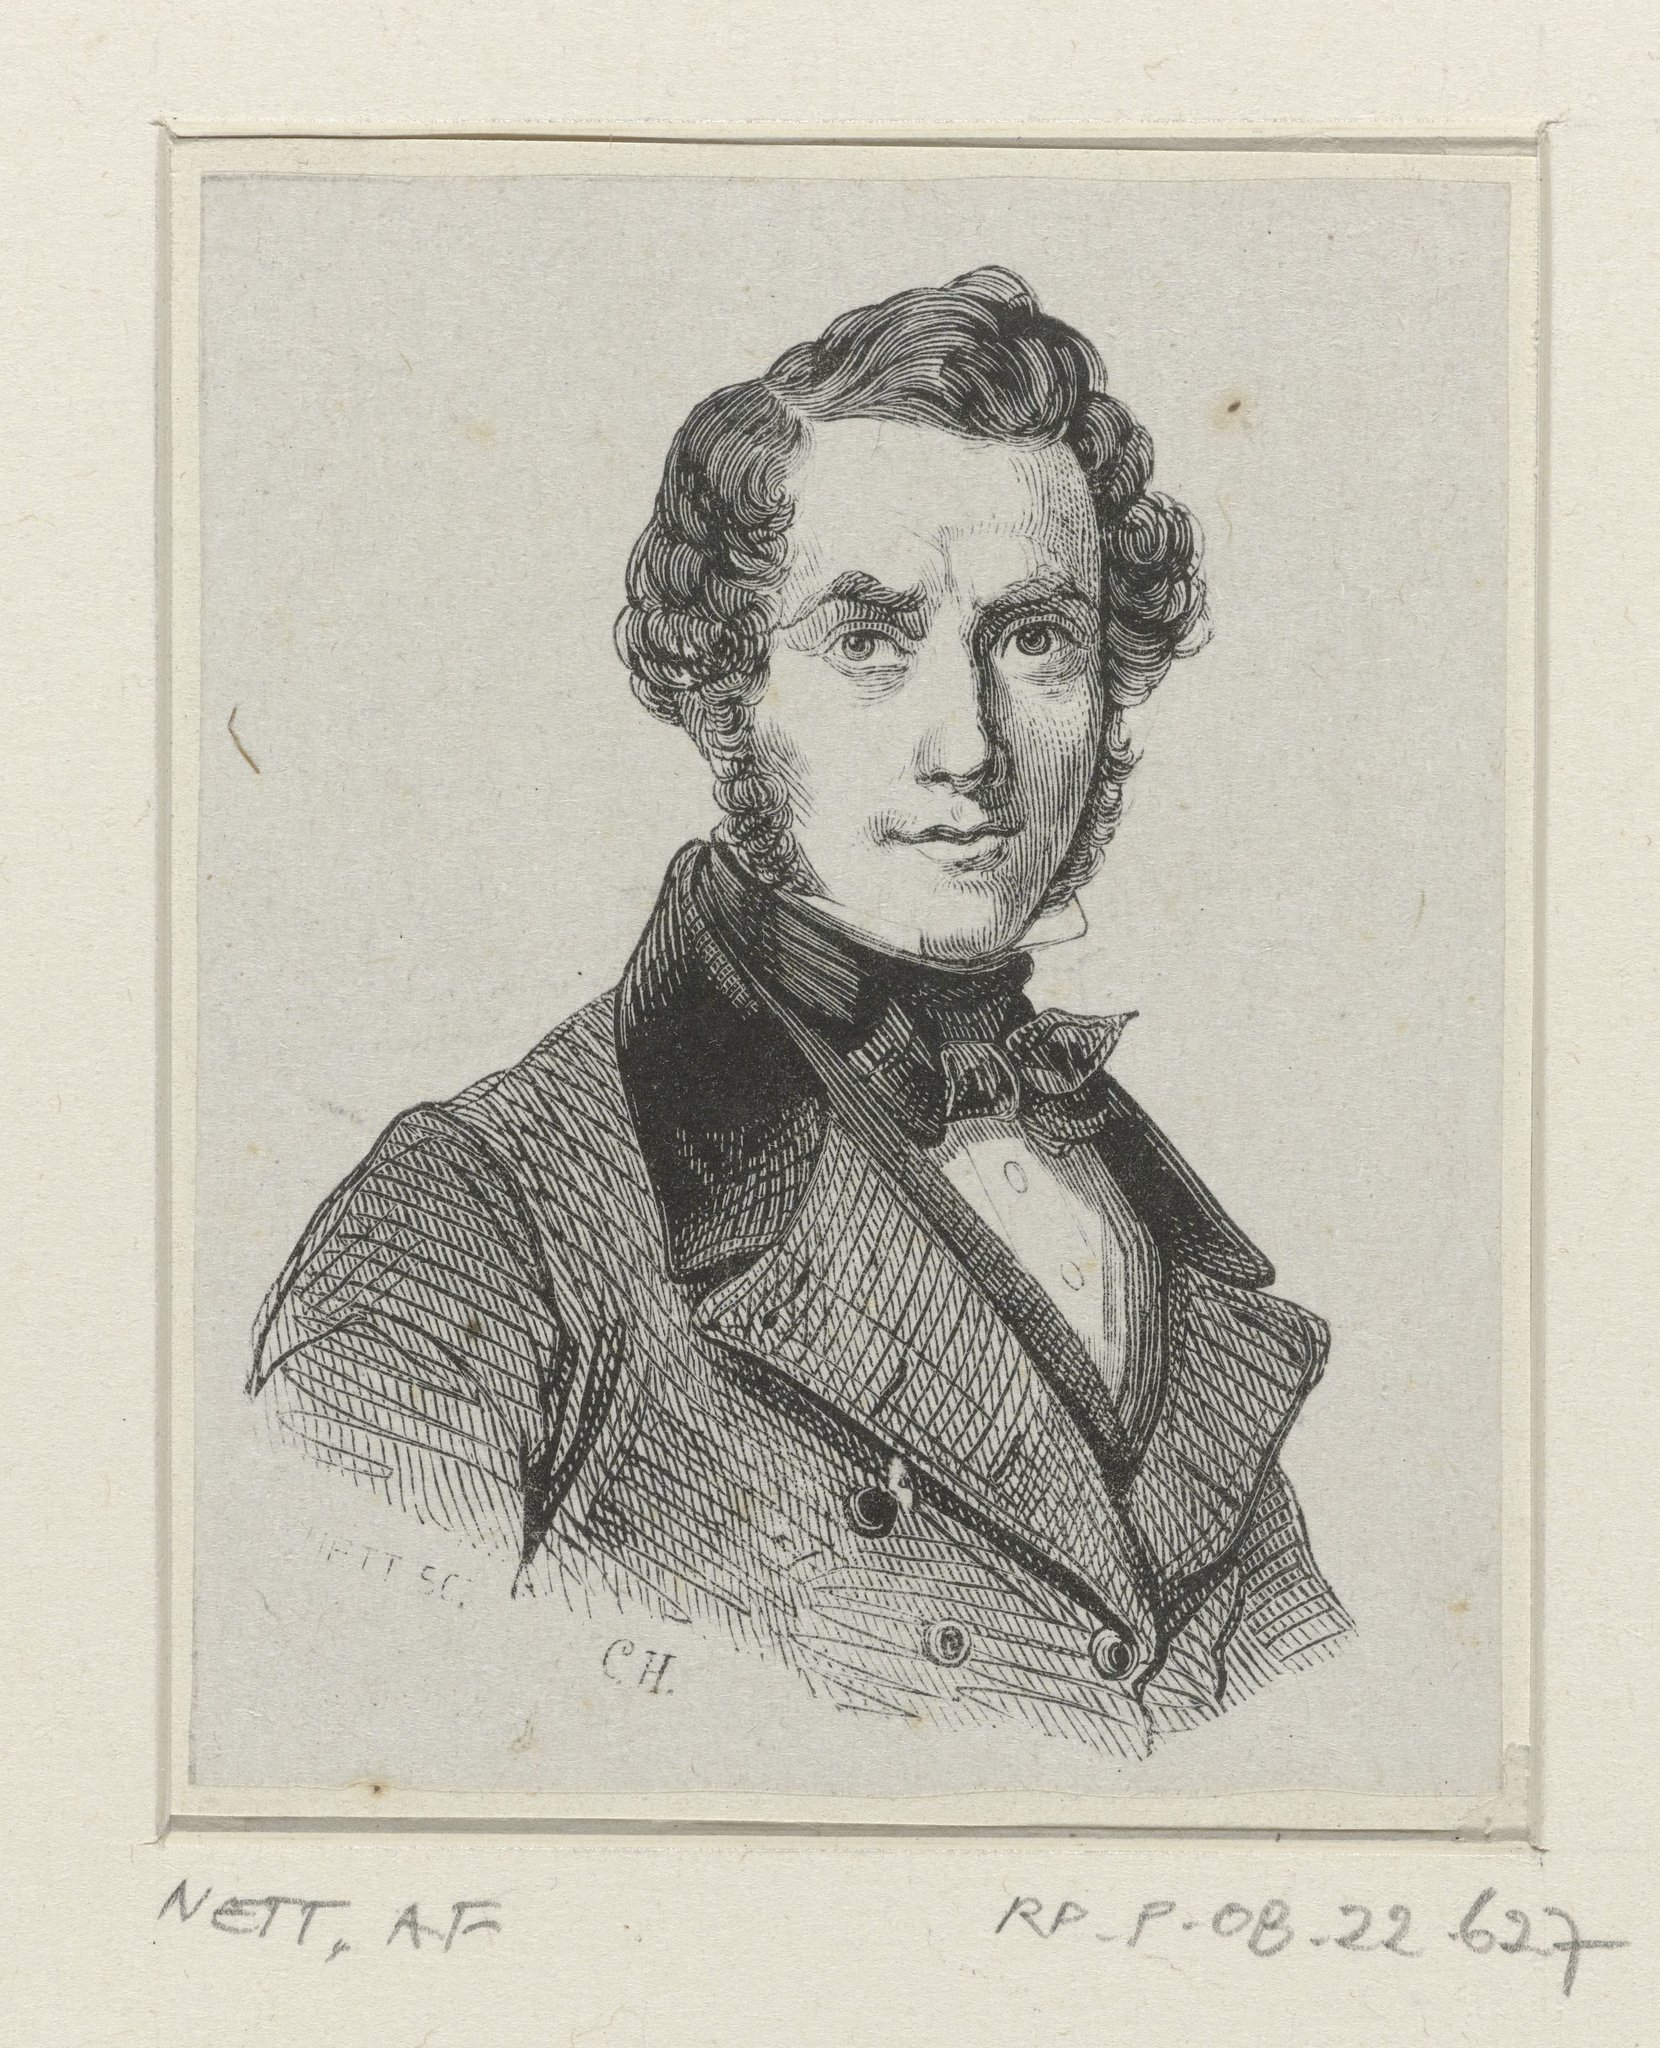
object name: print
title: Zelfportret van Antonius van Ysendyck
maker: adolphe frédéric nett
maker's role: print maker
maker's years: 1822-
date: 1832-1900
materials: paper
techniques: engraving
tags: antwerp, brussels, print maker, draughtsman, antoon van ijsendijck, historical persons, portrait, self-portrait of artist, portrait, self-portrait of graphic artist, portrait, self-portrait of draughtsman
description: Zelfportret van graveur en tekenaar Antonius van Ysendyck.